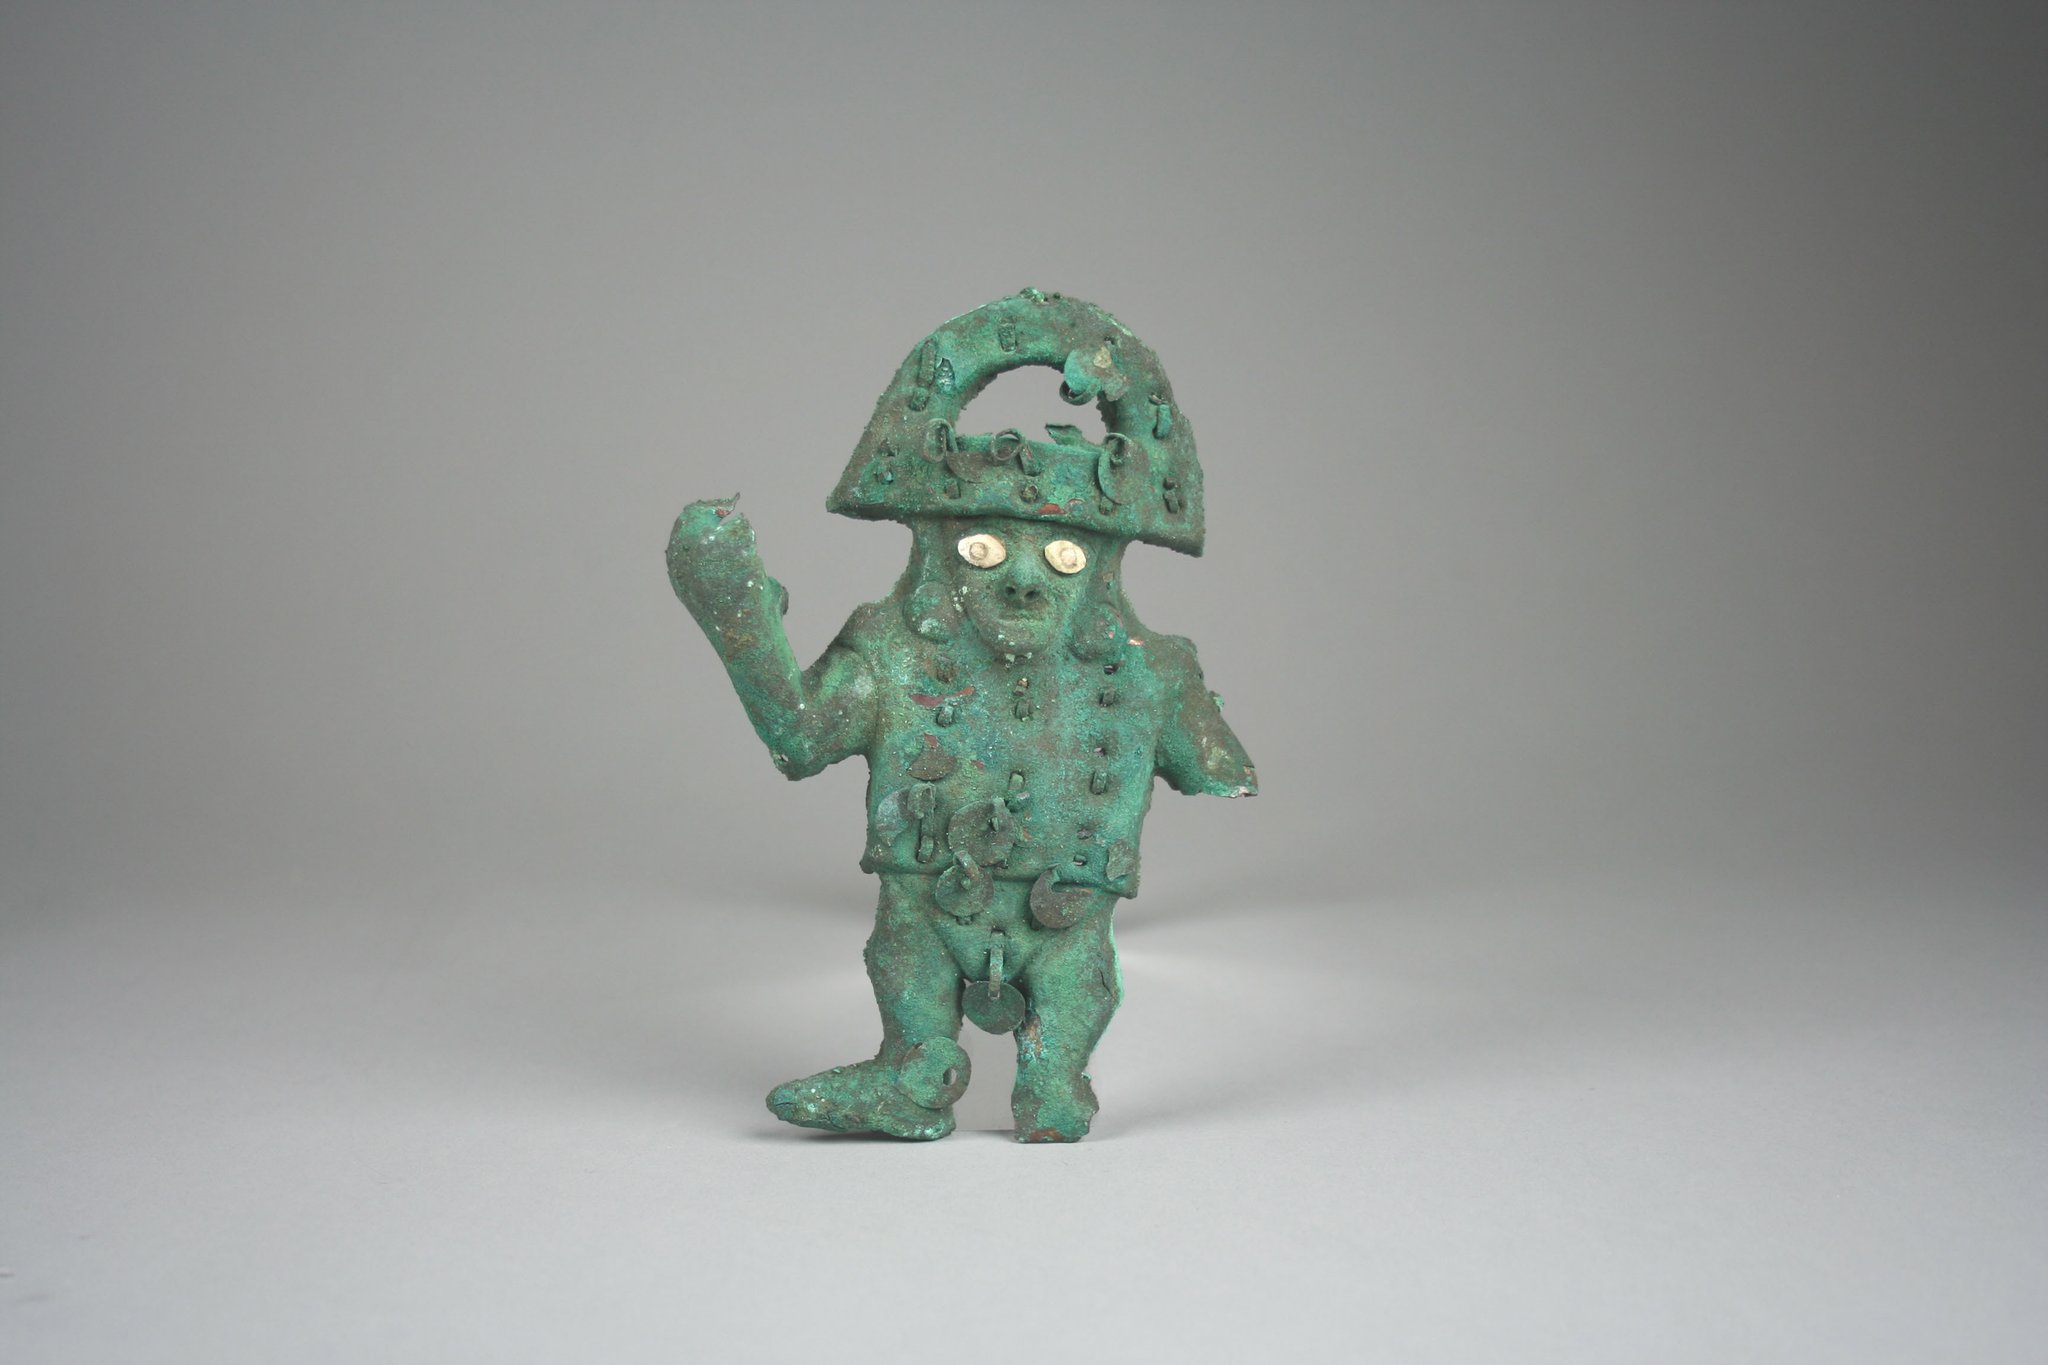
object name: ornament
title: Profile Warrior Ornament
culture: moche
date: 501-700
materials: gilt copper, shell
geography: peru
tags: warriors